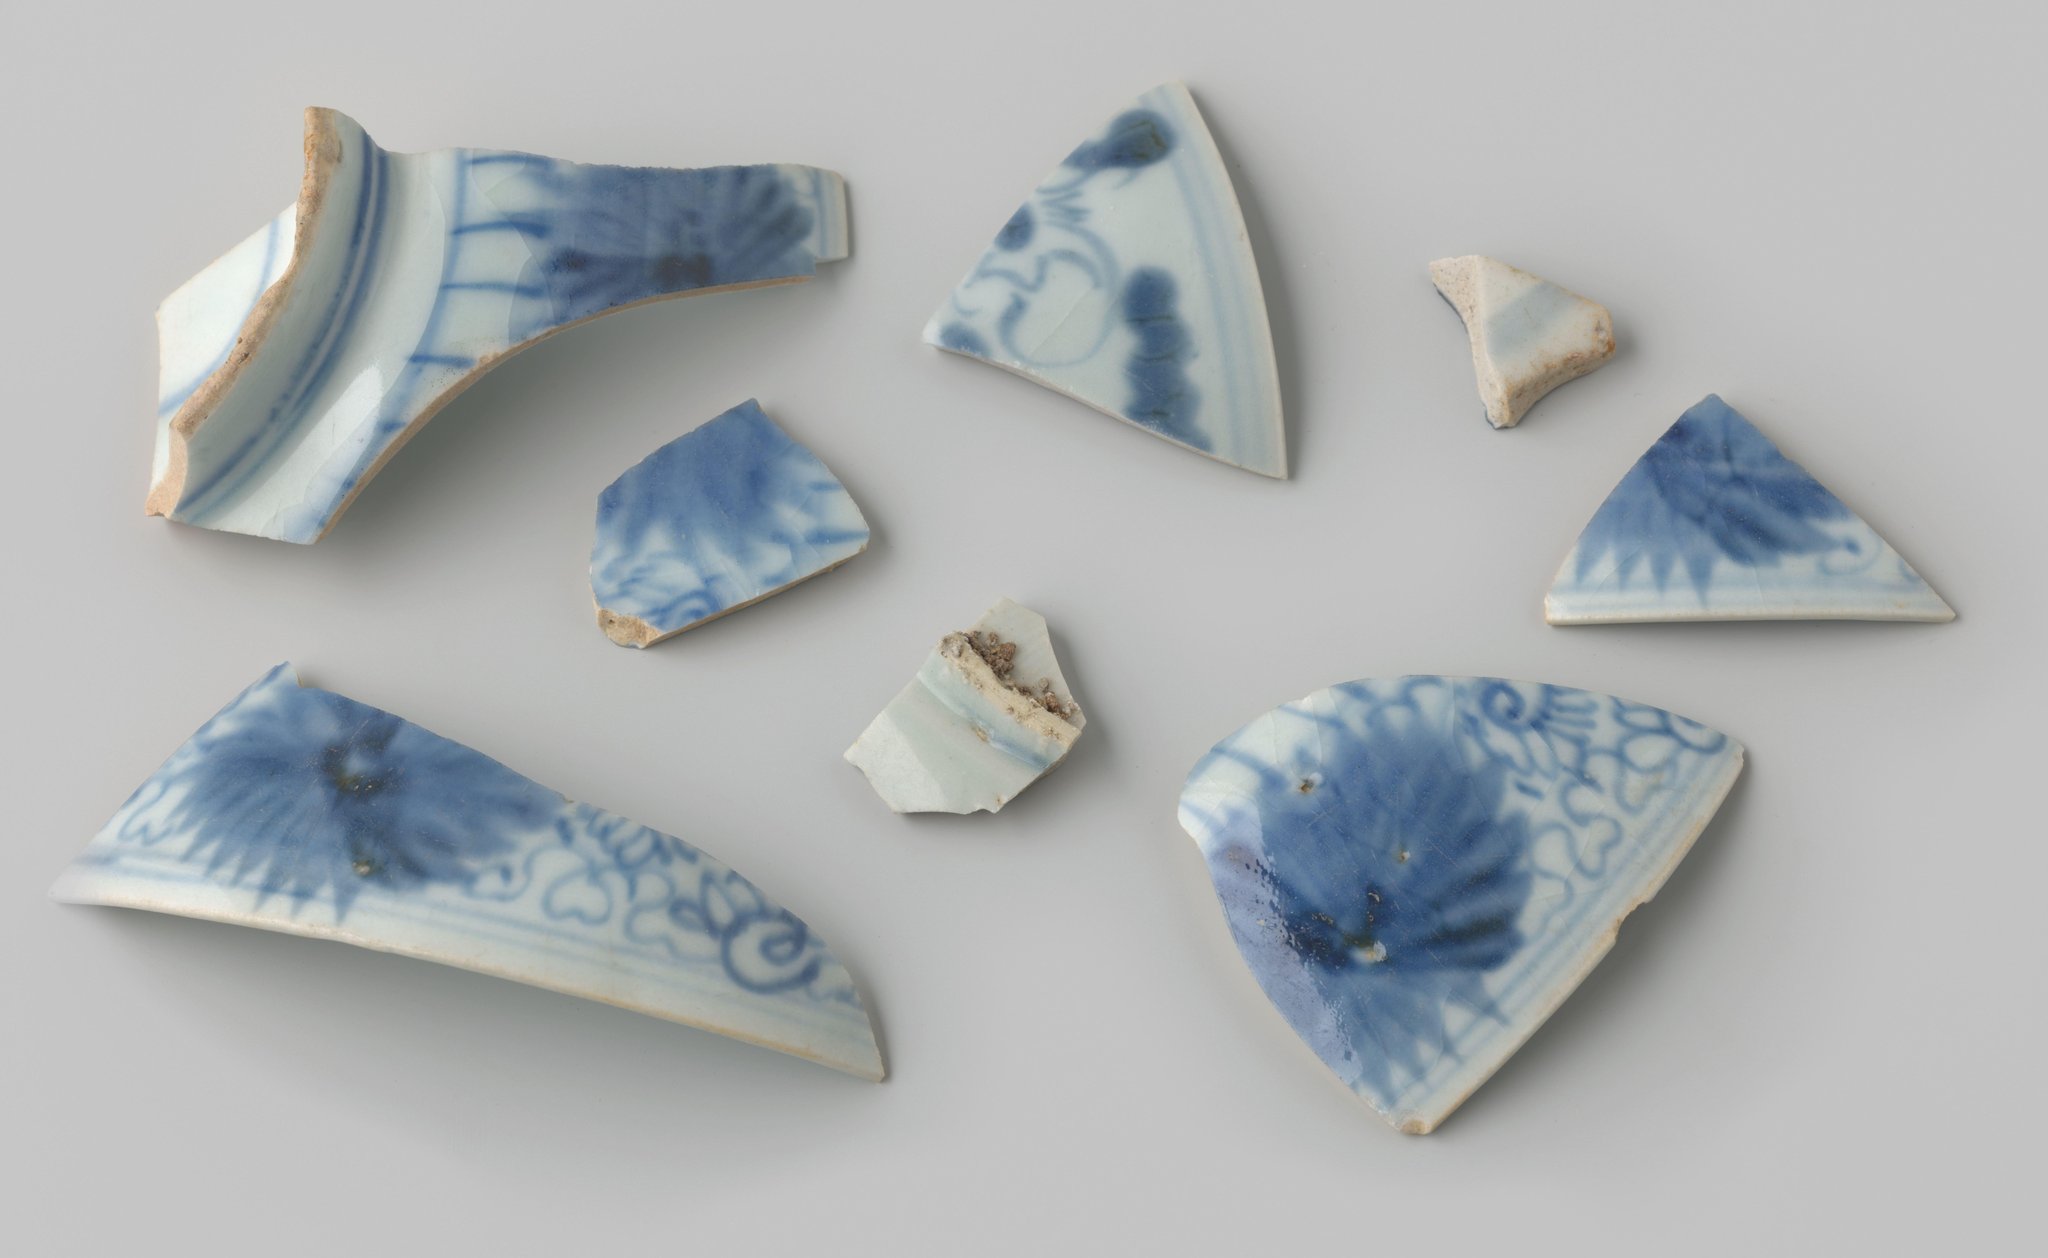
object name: bowl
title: Scherven van kommen uit V.O.C.-schip de 'Witte Leeuw'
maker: Anonymous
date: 1613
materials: porcelain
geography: jingdezhen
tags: verenigde oostindische compagnie, sint-helena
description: A base sherd. In the centre part of a shrimp (?) is visible. On the base part of a 4-character mark: fu kuei...